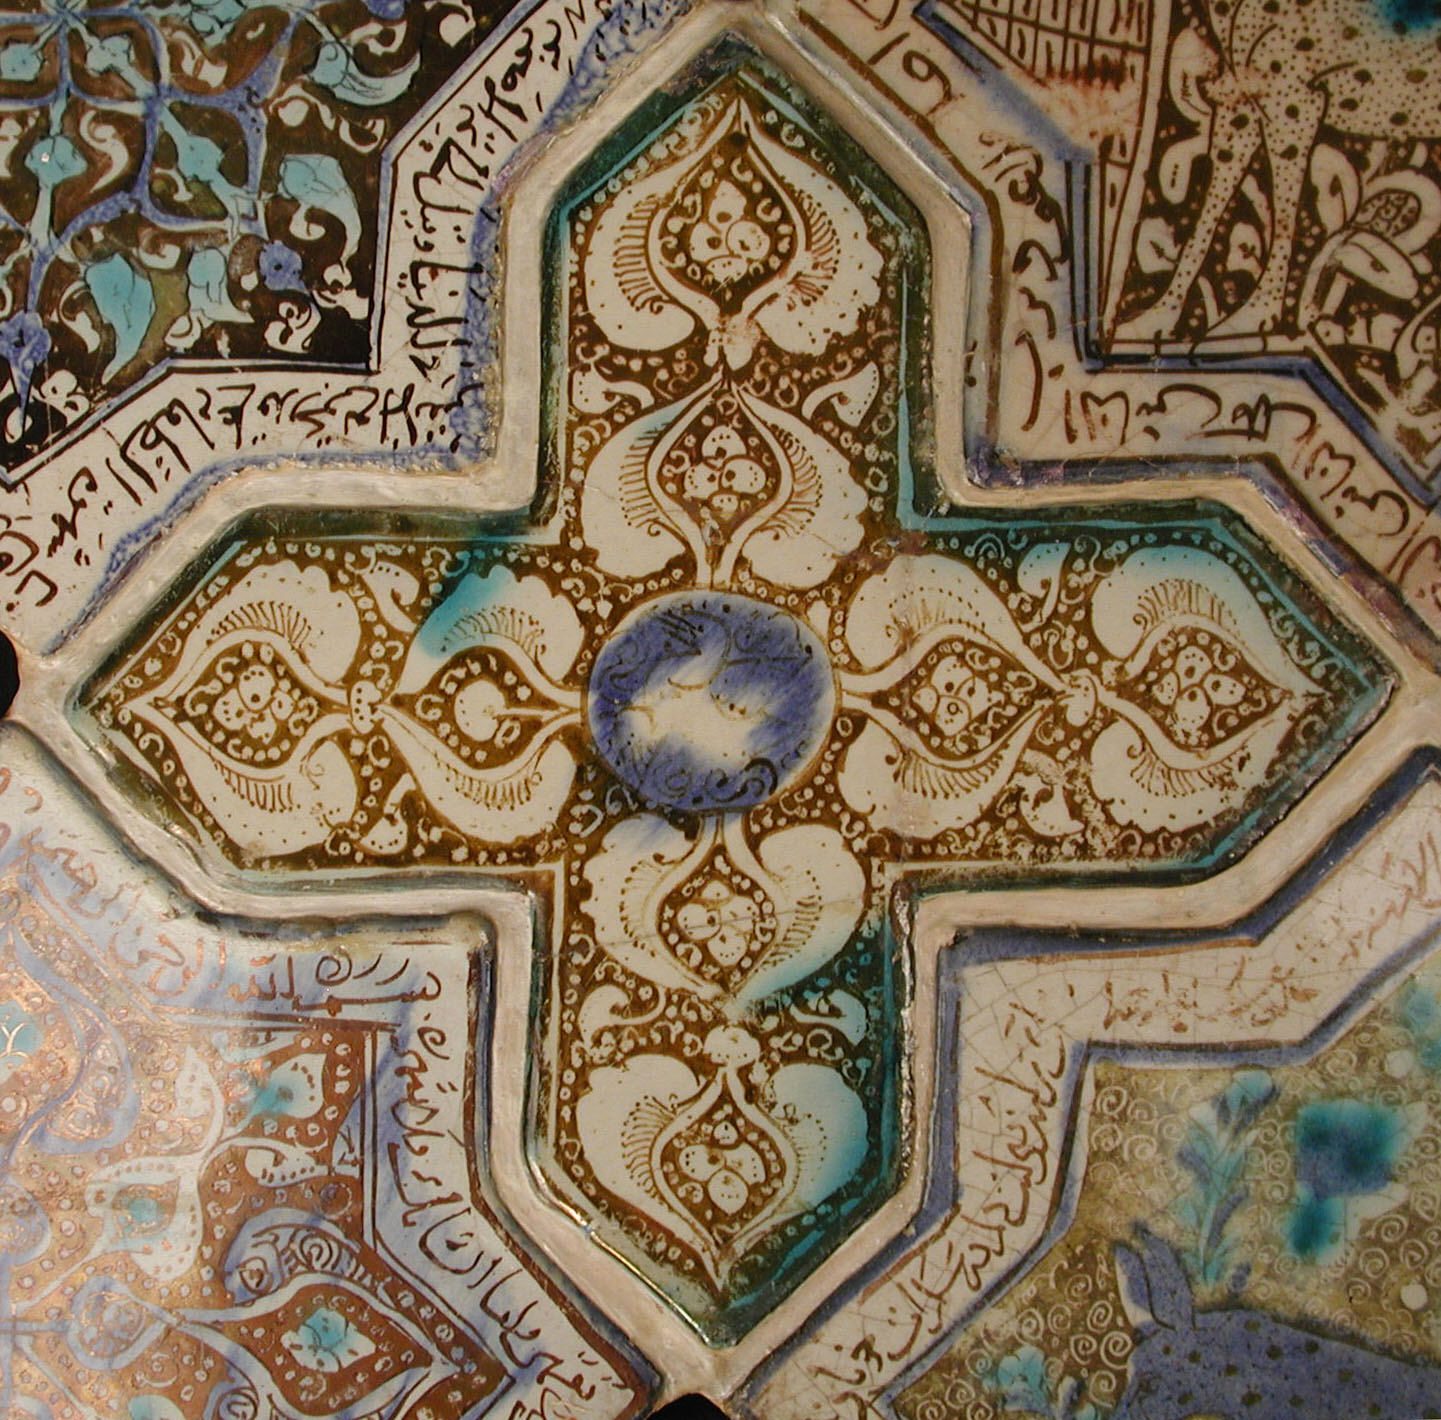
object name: tile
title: Cross-Shaped Tile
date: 1201-1300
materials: glaze, stonepaste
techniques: luster painting, painting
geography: iran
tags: leaves,cross